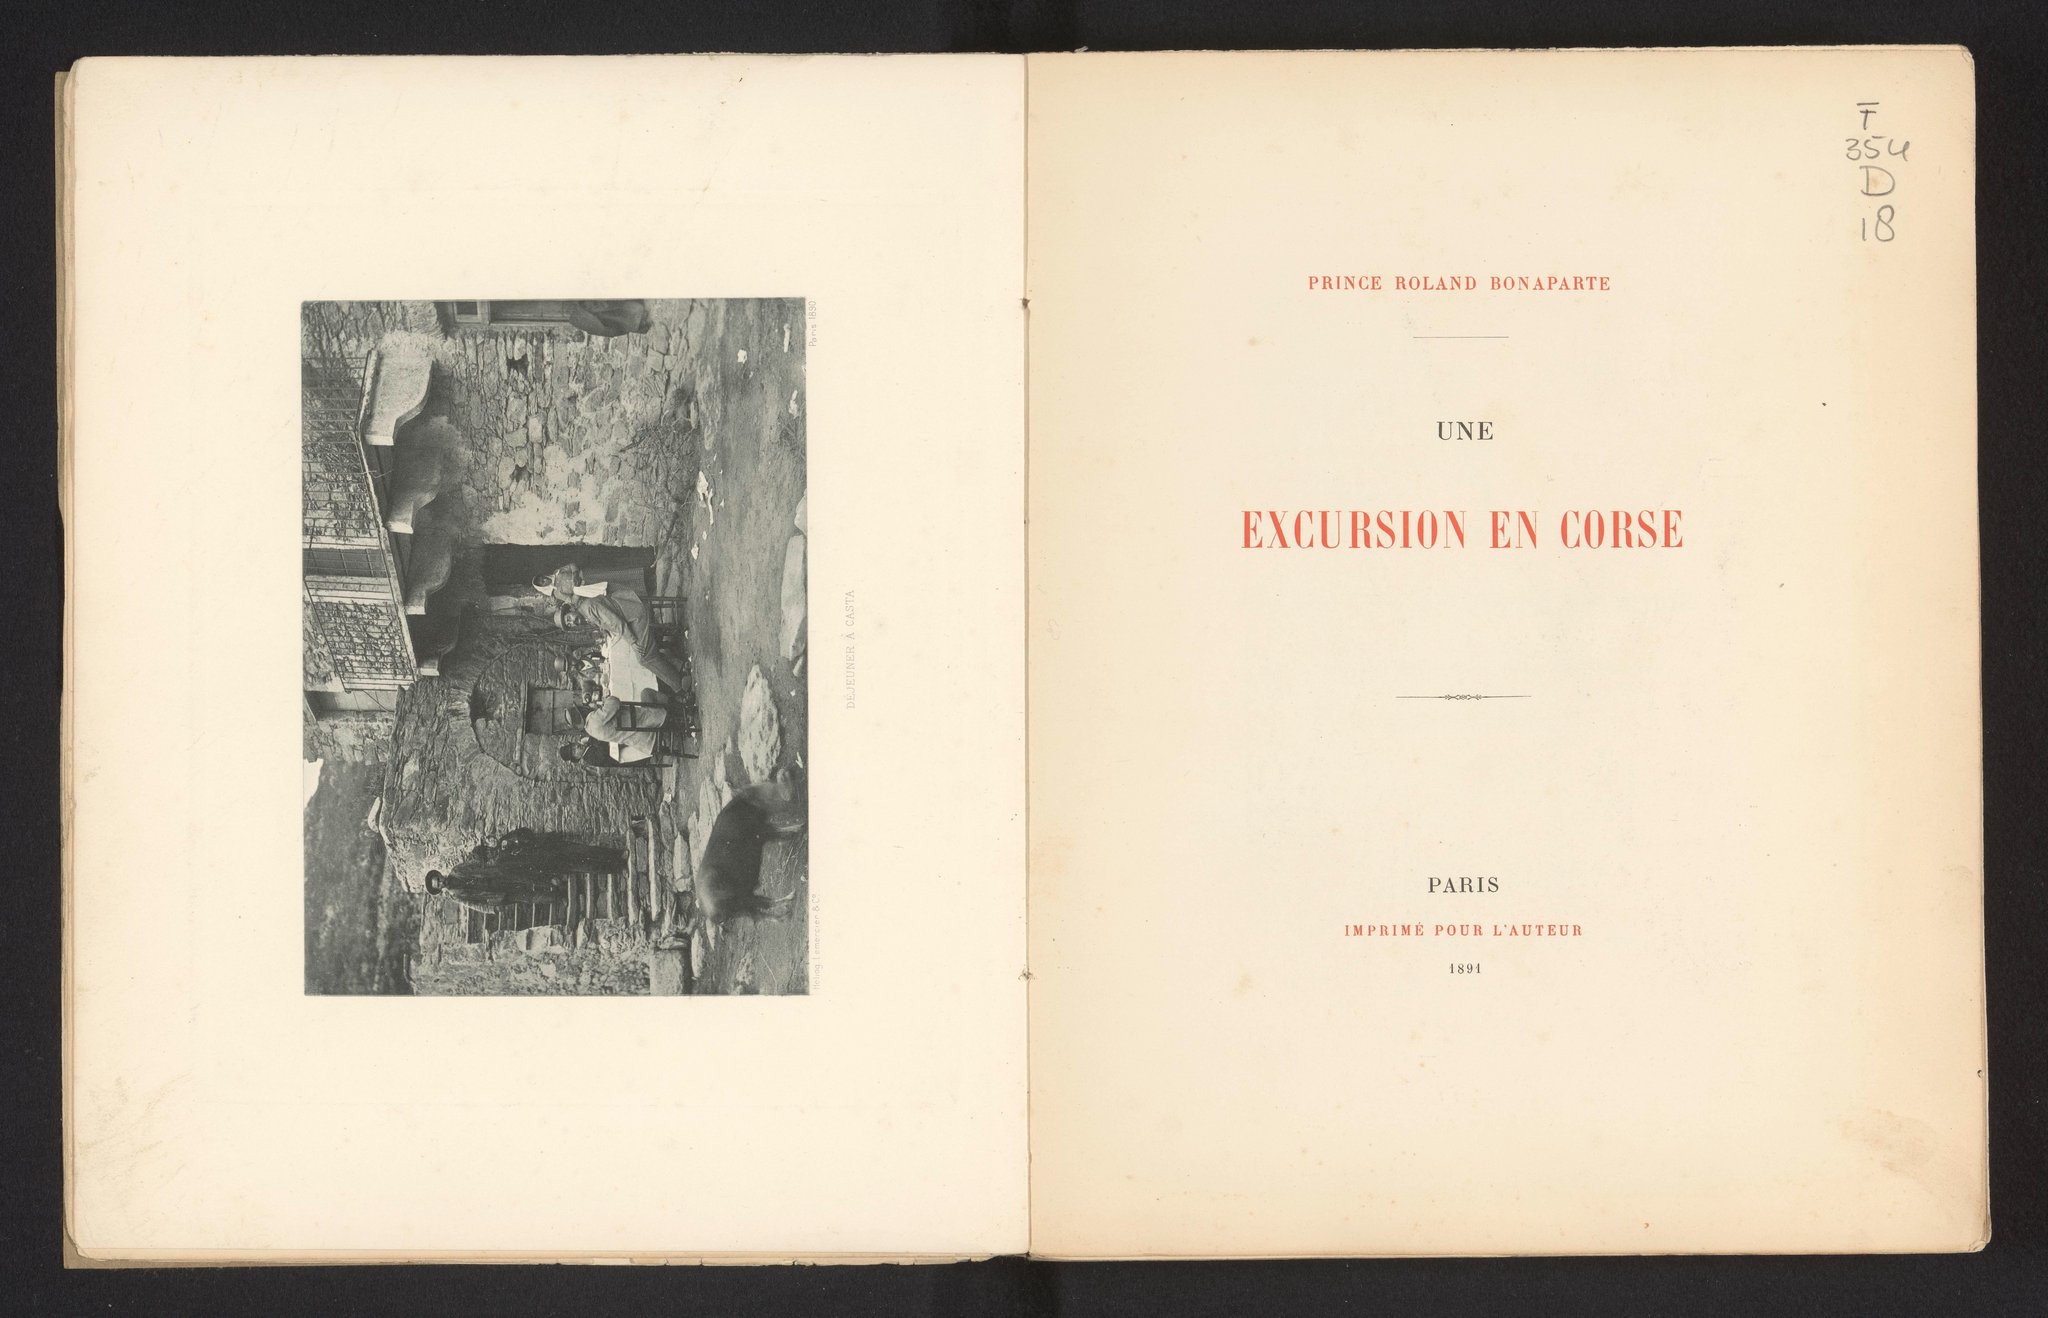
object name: book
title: Une excursion en Corse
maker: roland napoleon bonaparte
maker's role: botanicus, fotograaf, geograaf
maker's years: 1858-1924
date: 1891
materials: paper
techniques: photoaquatint, printing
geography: paris